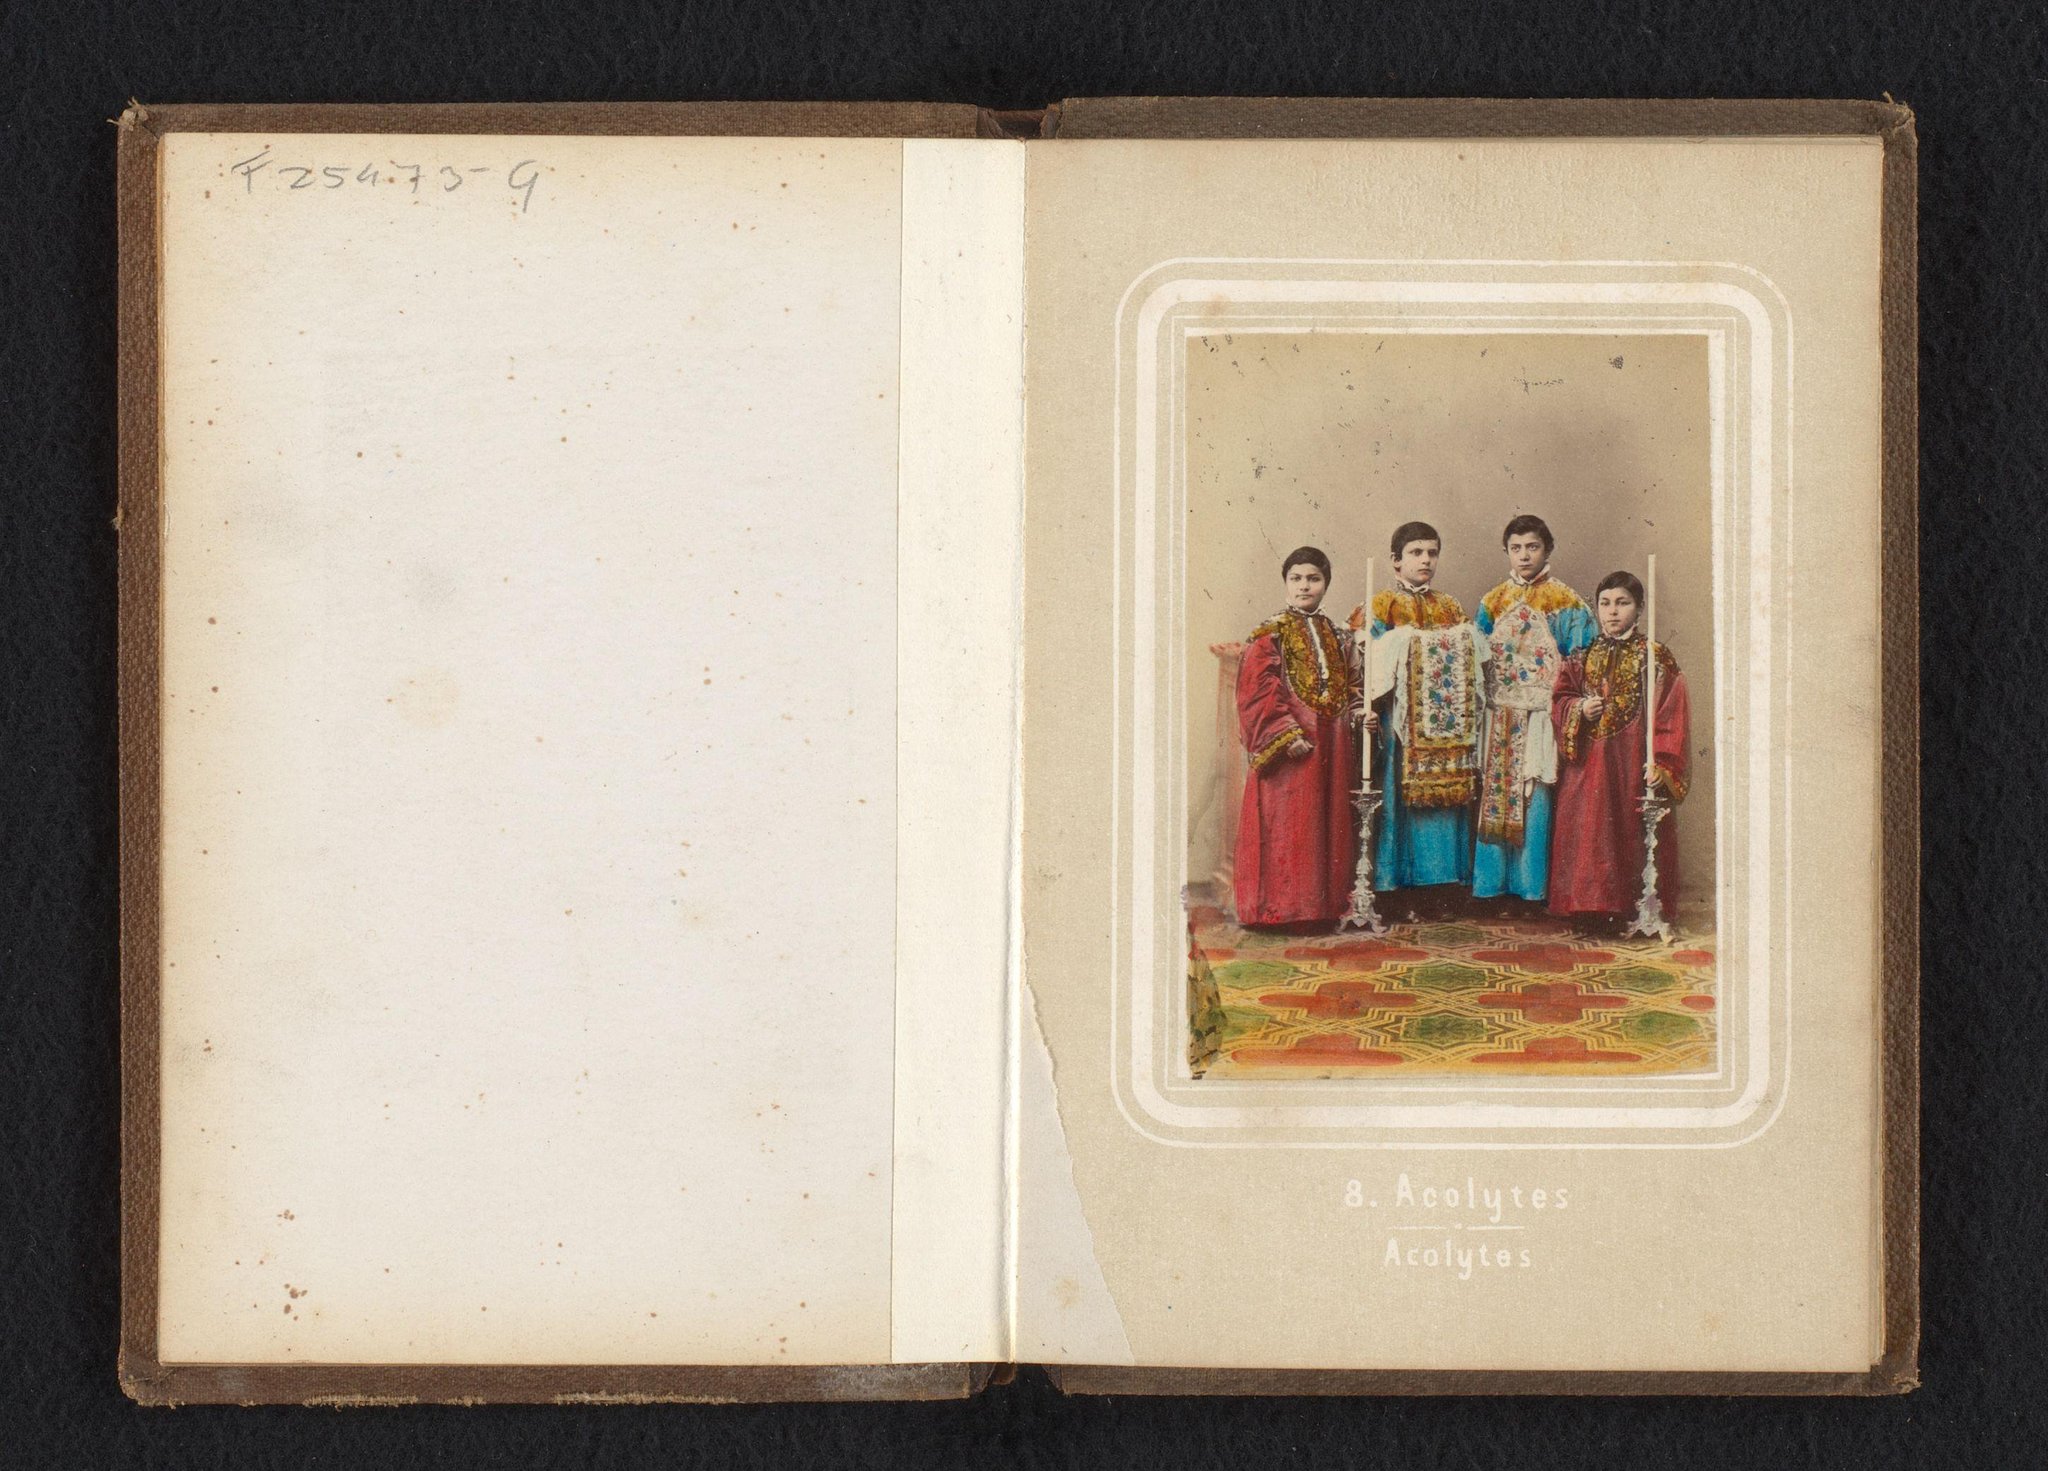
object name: page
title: Portret van vier onbekende acolieten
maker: Anonymous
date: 1870-1890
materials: paper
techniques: albumen print, hand coloring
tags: acolyte, chorister, lector, ostiarius, etc. ~ functionaries in roman catholic church, anonymous historical person portrayed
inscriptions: number: ‘8.’